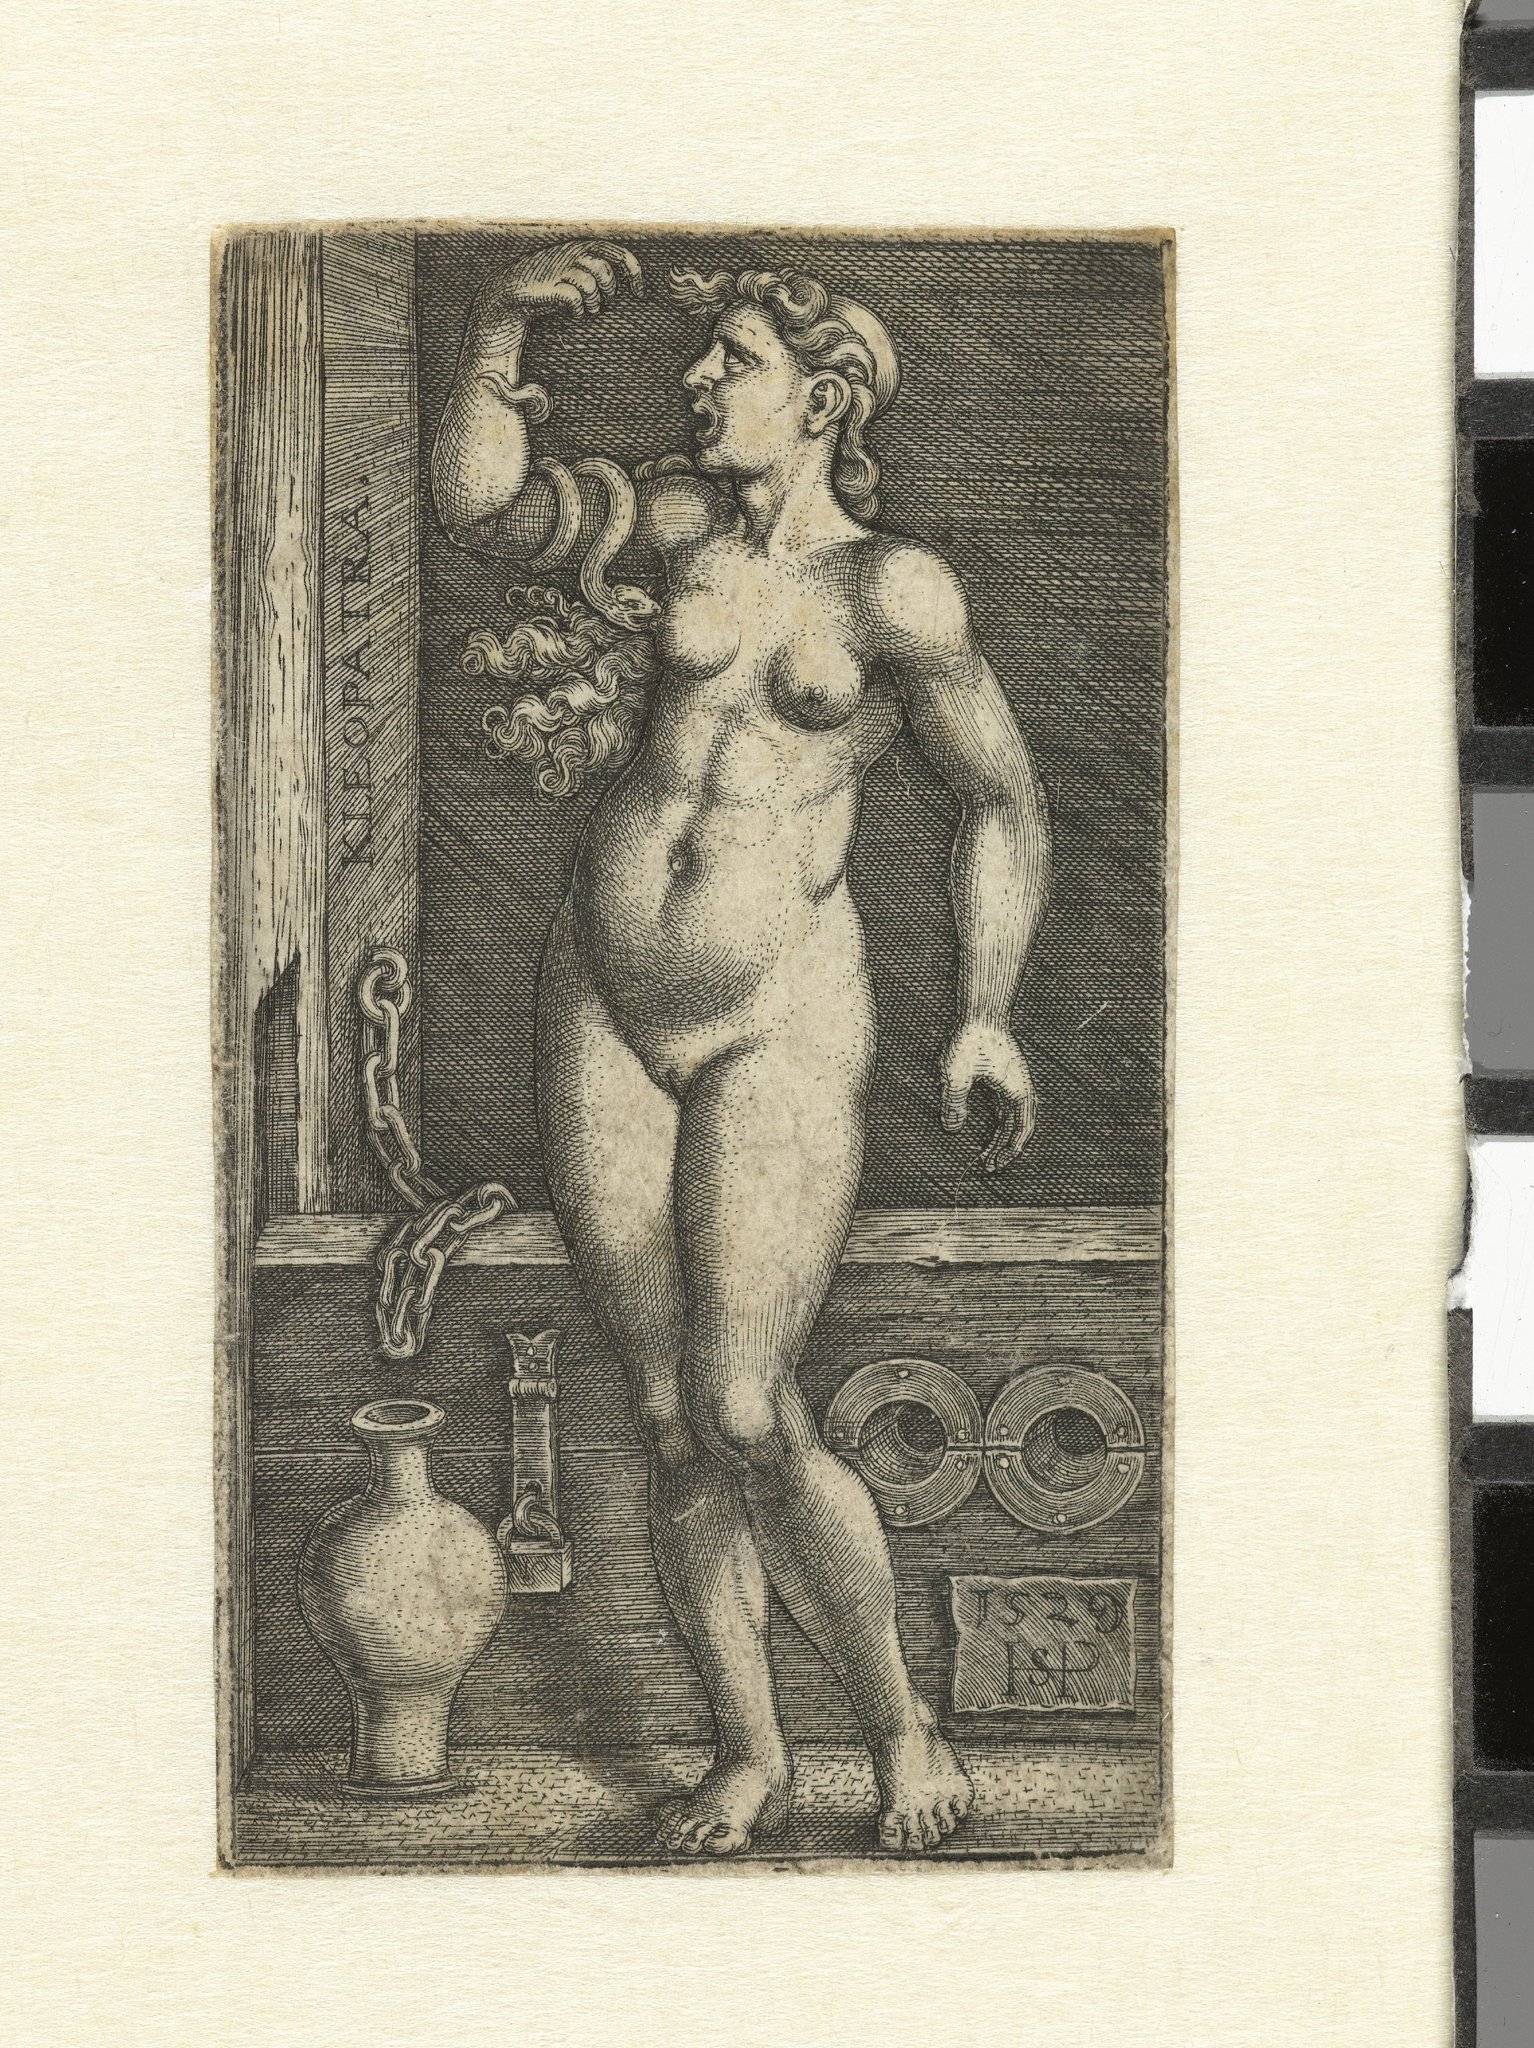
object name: print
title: Kleopatra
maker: hans sebald beham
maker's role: designer, draughtsman, print maker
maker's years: 1500-1550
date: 1529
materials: paper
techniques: engraving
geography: germany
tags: death of cleopatra: she commits suicide by holding to her breast an asp, which she has taken from a basket of figs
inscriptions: collector's mark: Lugt 2228a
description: Cleopatra staand in een gevangeniscel met een lijdende uitdrukking op haar gezicht. Zij pleegt zelfmoord met een slang die in haar borst bijt.